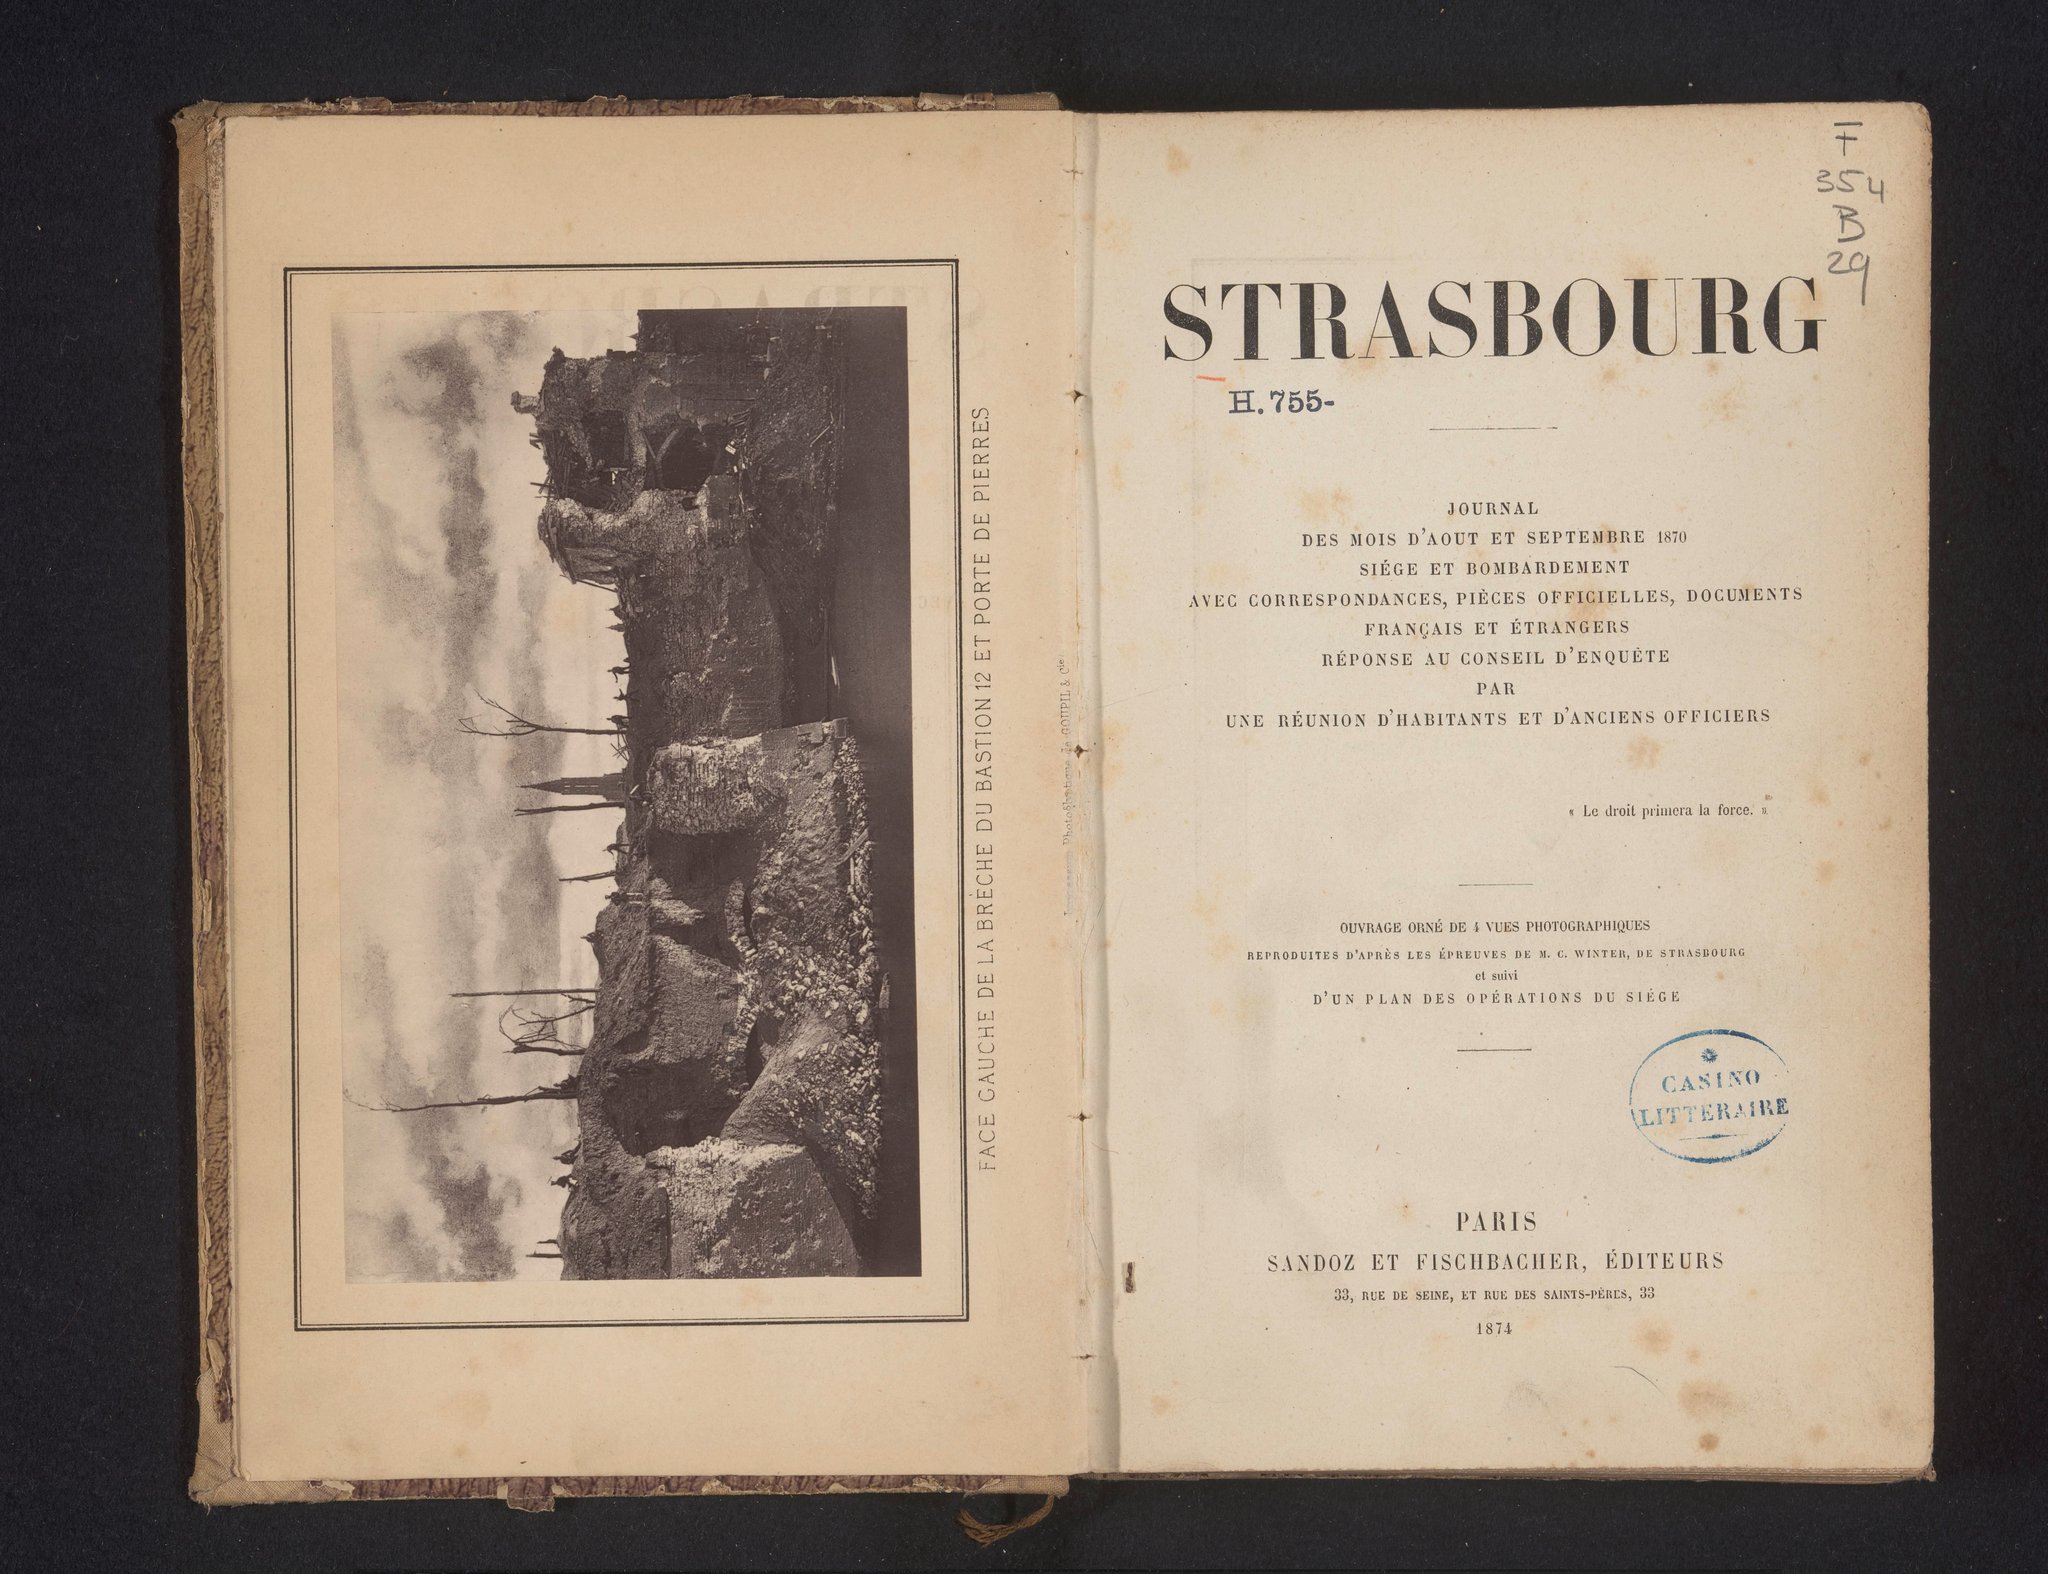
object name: book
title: Strasbourg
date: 1874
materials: cardboard, paper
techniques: lithograph, printing, woodburytype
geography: paris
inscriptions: inscription: ‘casino litteraire’